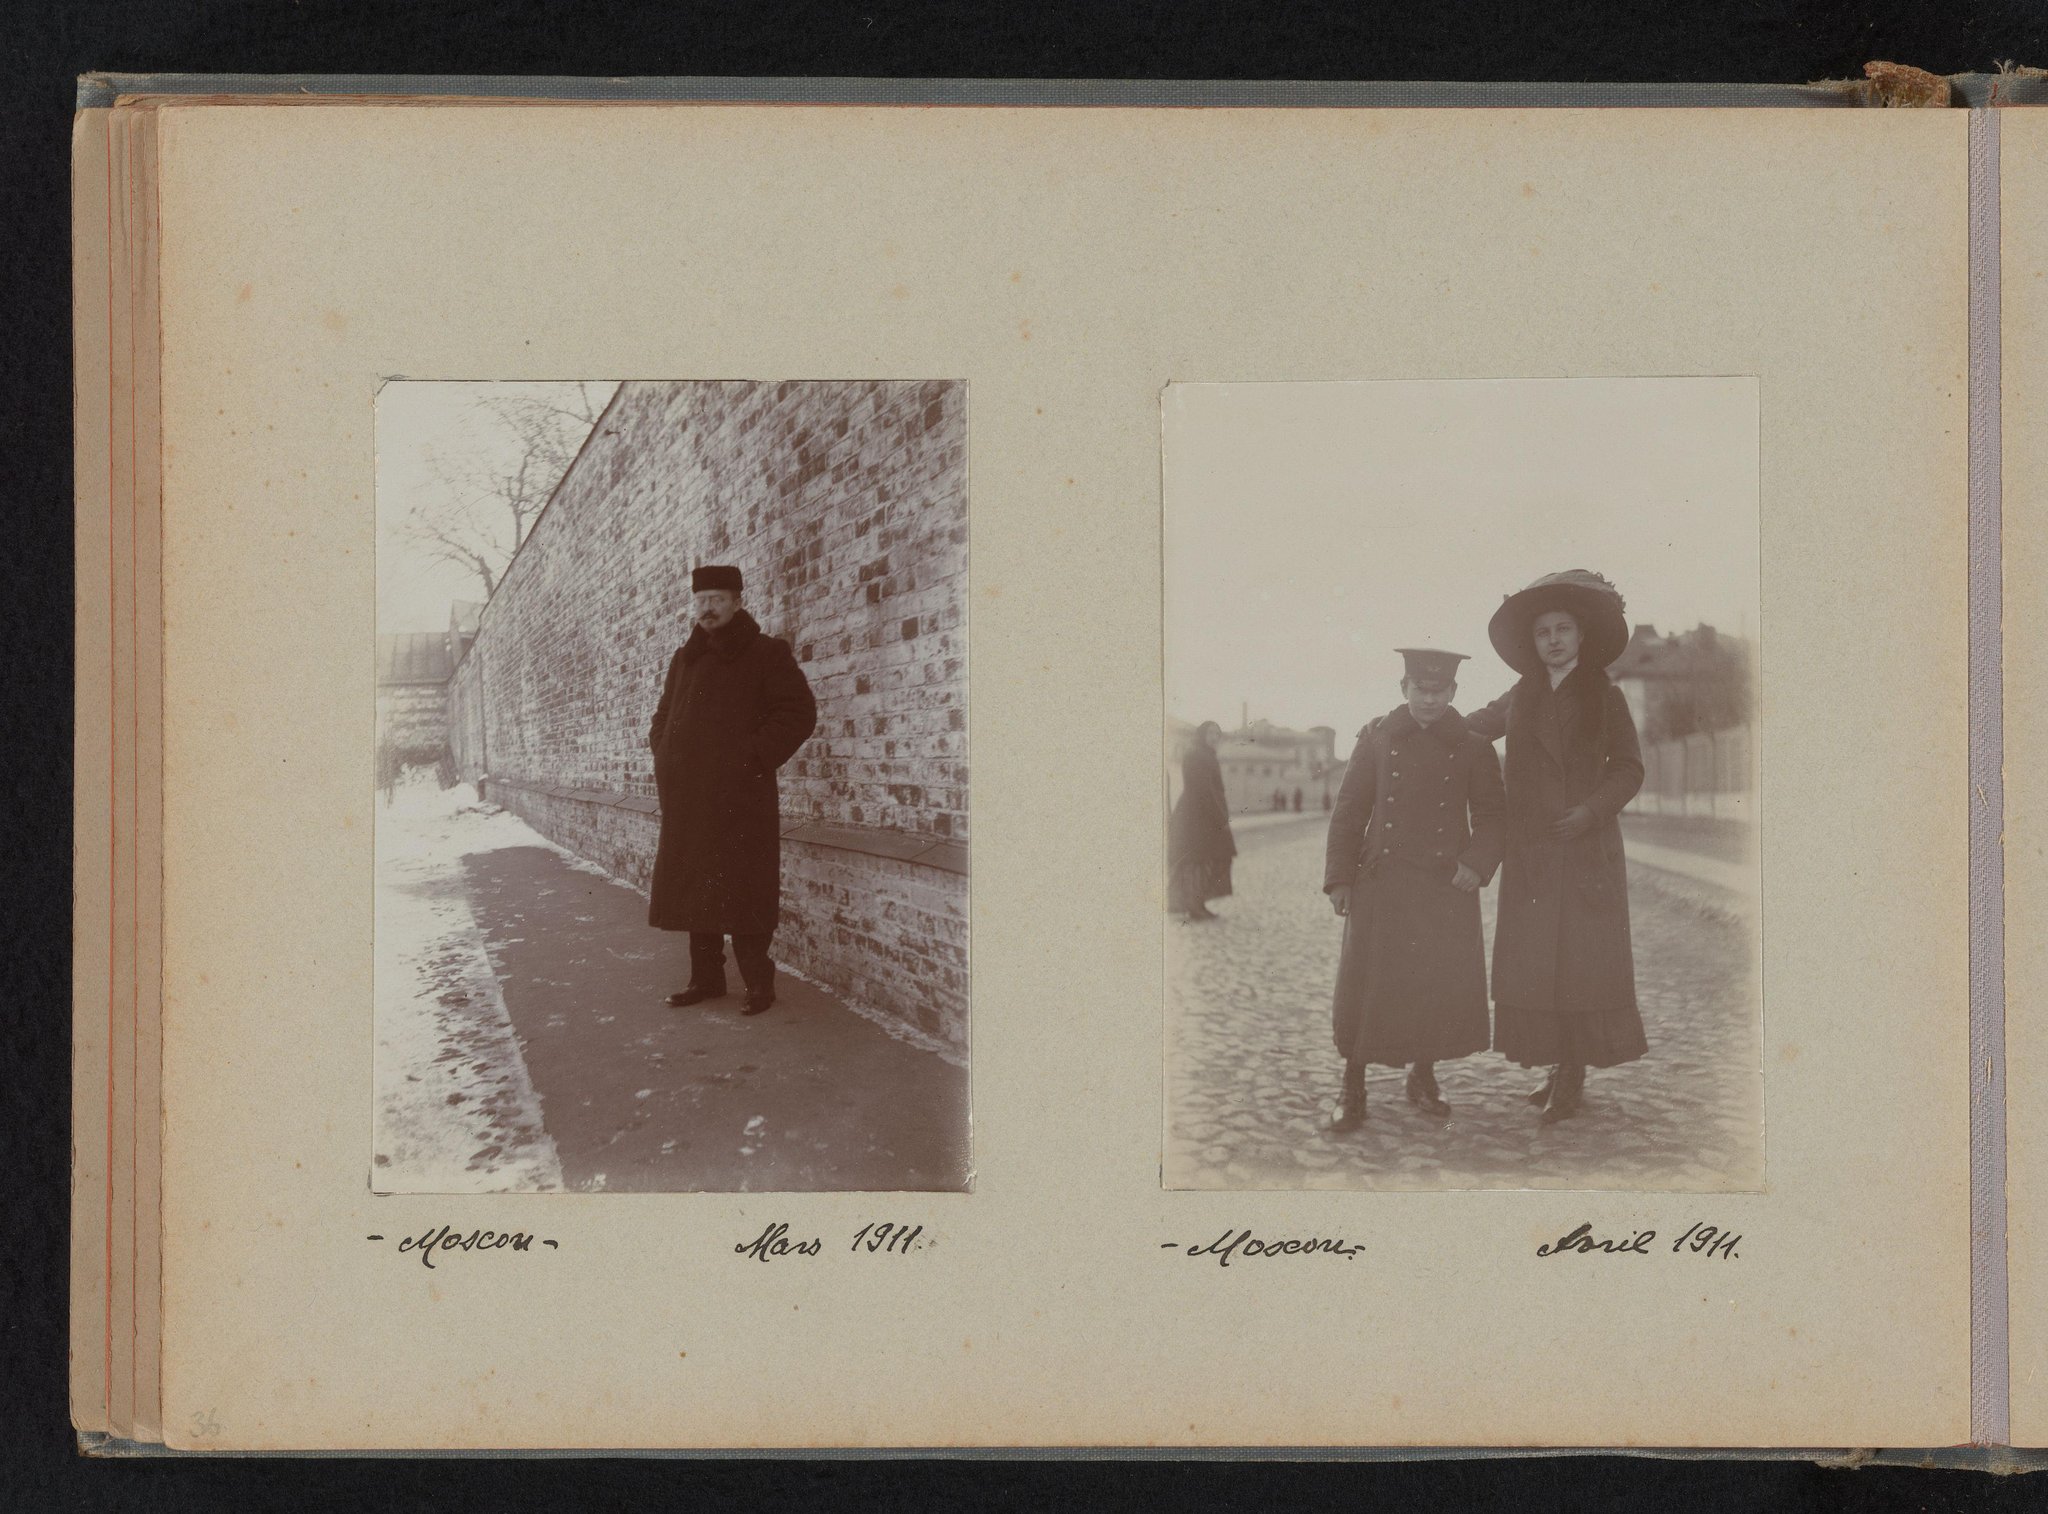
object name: album leaf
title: Man bij een muur op straat en een jongeman en vrouw op straat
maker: Anonymous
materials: paper, cardboard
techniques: collodion silver print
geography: moscow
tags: historical persons, street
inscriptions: inscription: ‘- Moscou - Mars 1911.’, inscription: ‘- Moscou - Avril 1911.’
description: Deze foto's maken deel uit van een album.